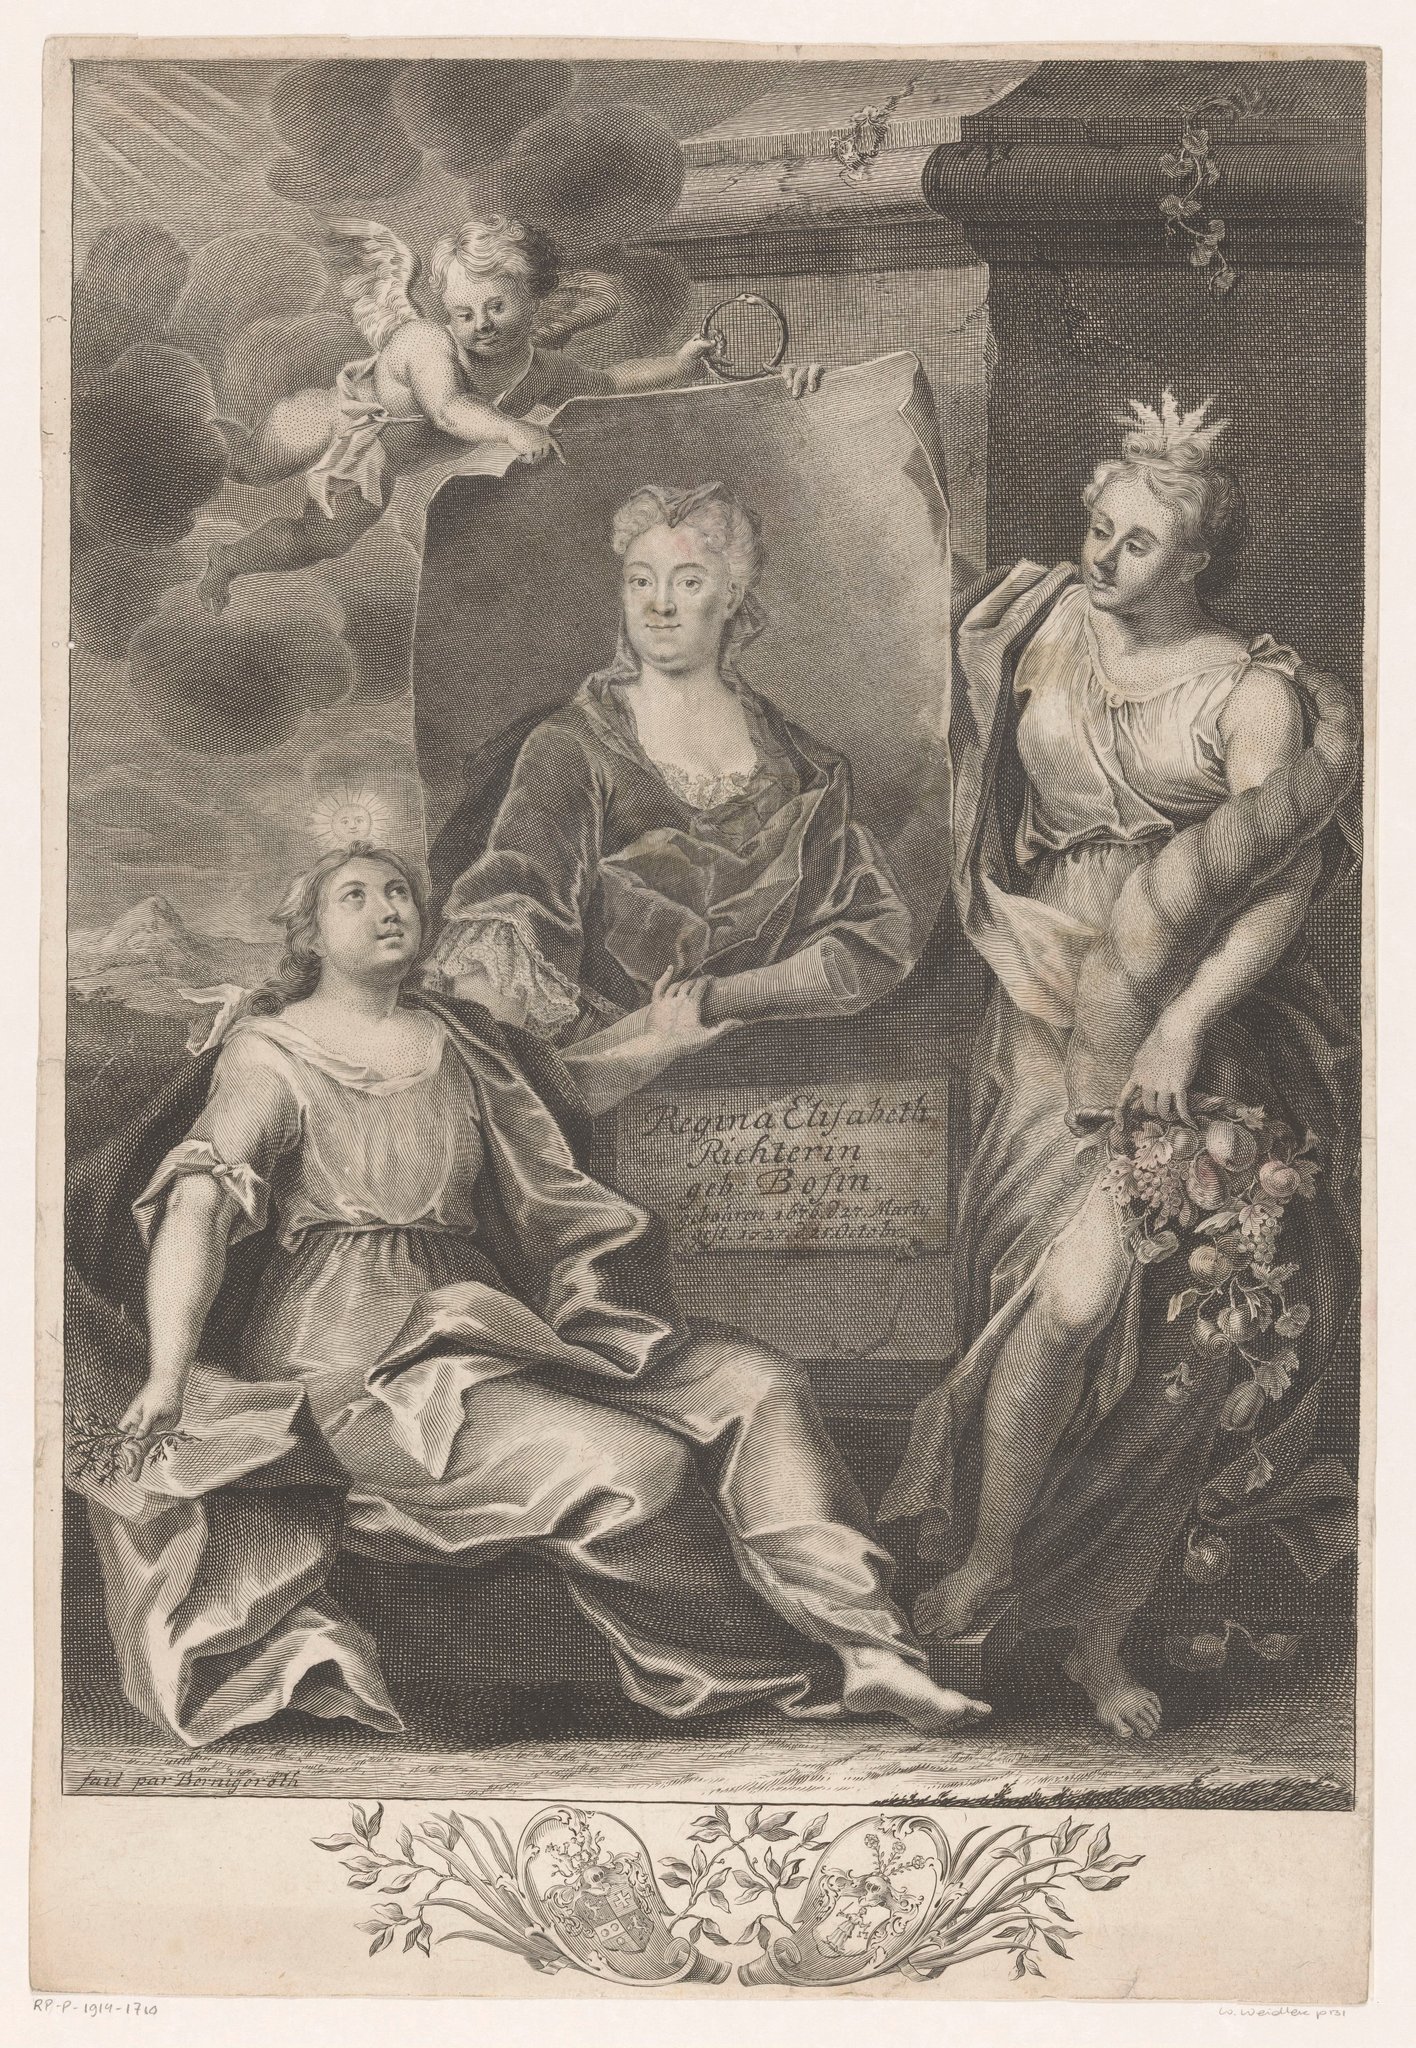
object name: print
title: Portret van Regina Elisabeth Richter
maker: martin bernigeroth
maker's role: print maker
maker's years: 1670-1733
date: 1727-1733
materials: paper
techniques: engraving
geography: leipzig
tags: 'cornucopia', horn of plenty, historical persons - bb - woman, truth; 'verità' (ripa), serpent ouroboros, luck, fortune, lot; 'fato', 'fortuna', 'fortuna aurea', 'fortuna buona', 'fortuna pacifica overo clemente', 'sorte' (ripa), armorial bearing, heraldry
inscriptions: collector's mark: Lugt 357, collector's mark: Lugt 2228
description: Allegorische voorstelling met links Waarheid (Veritas) en rechts het Lot (Fortuna) die het portret van Regina Elisabeth Richter omhoog houden. In de lucht zweeft een engel met een ouroboros in zijn rechterhand.